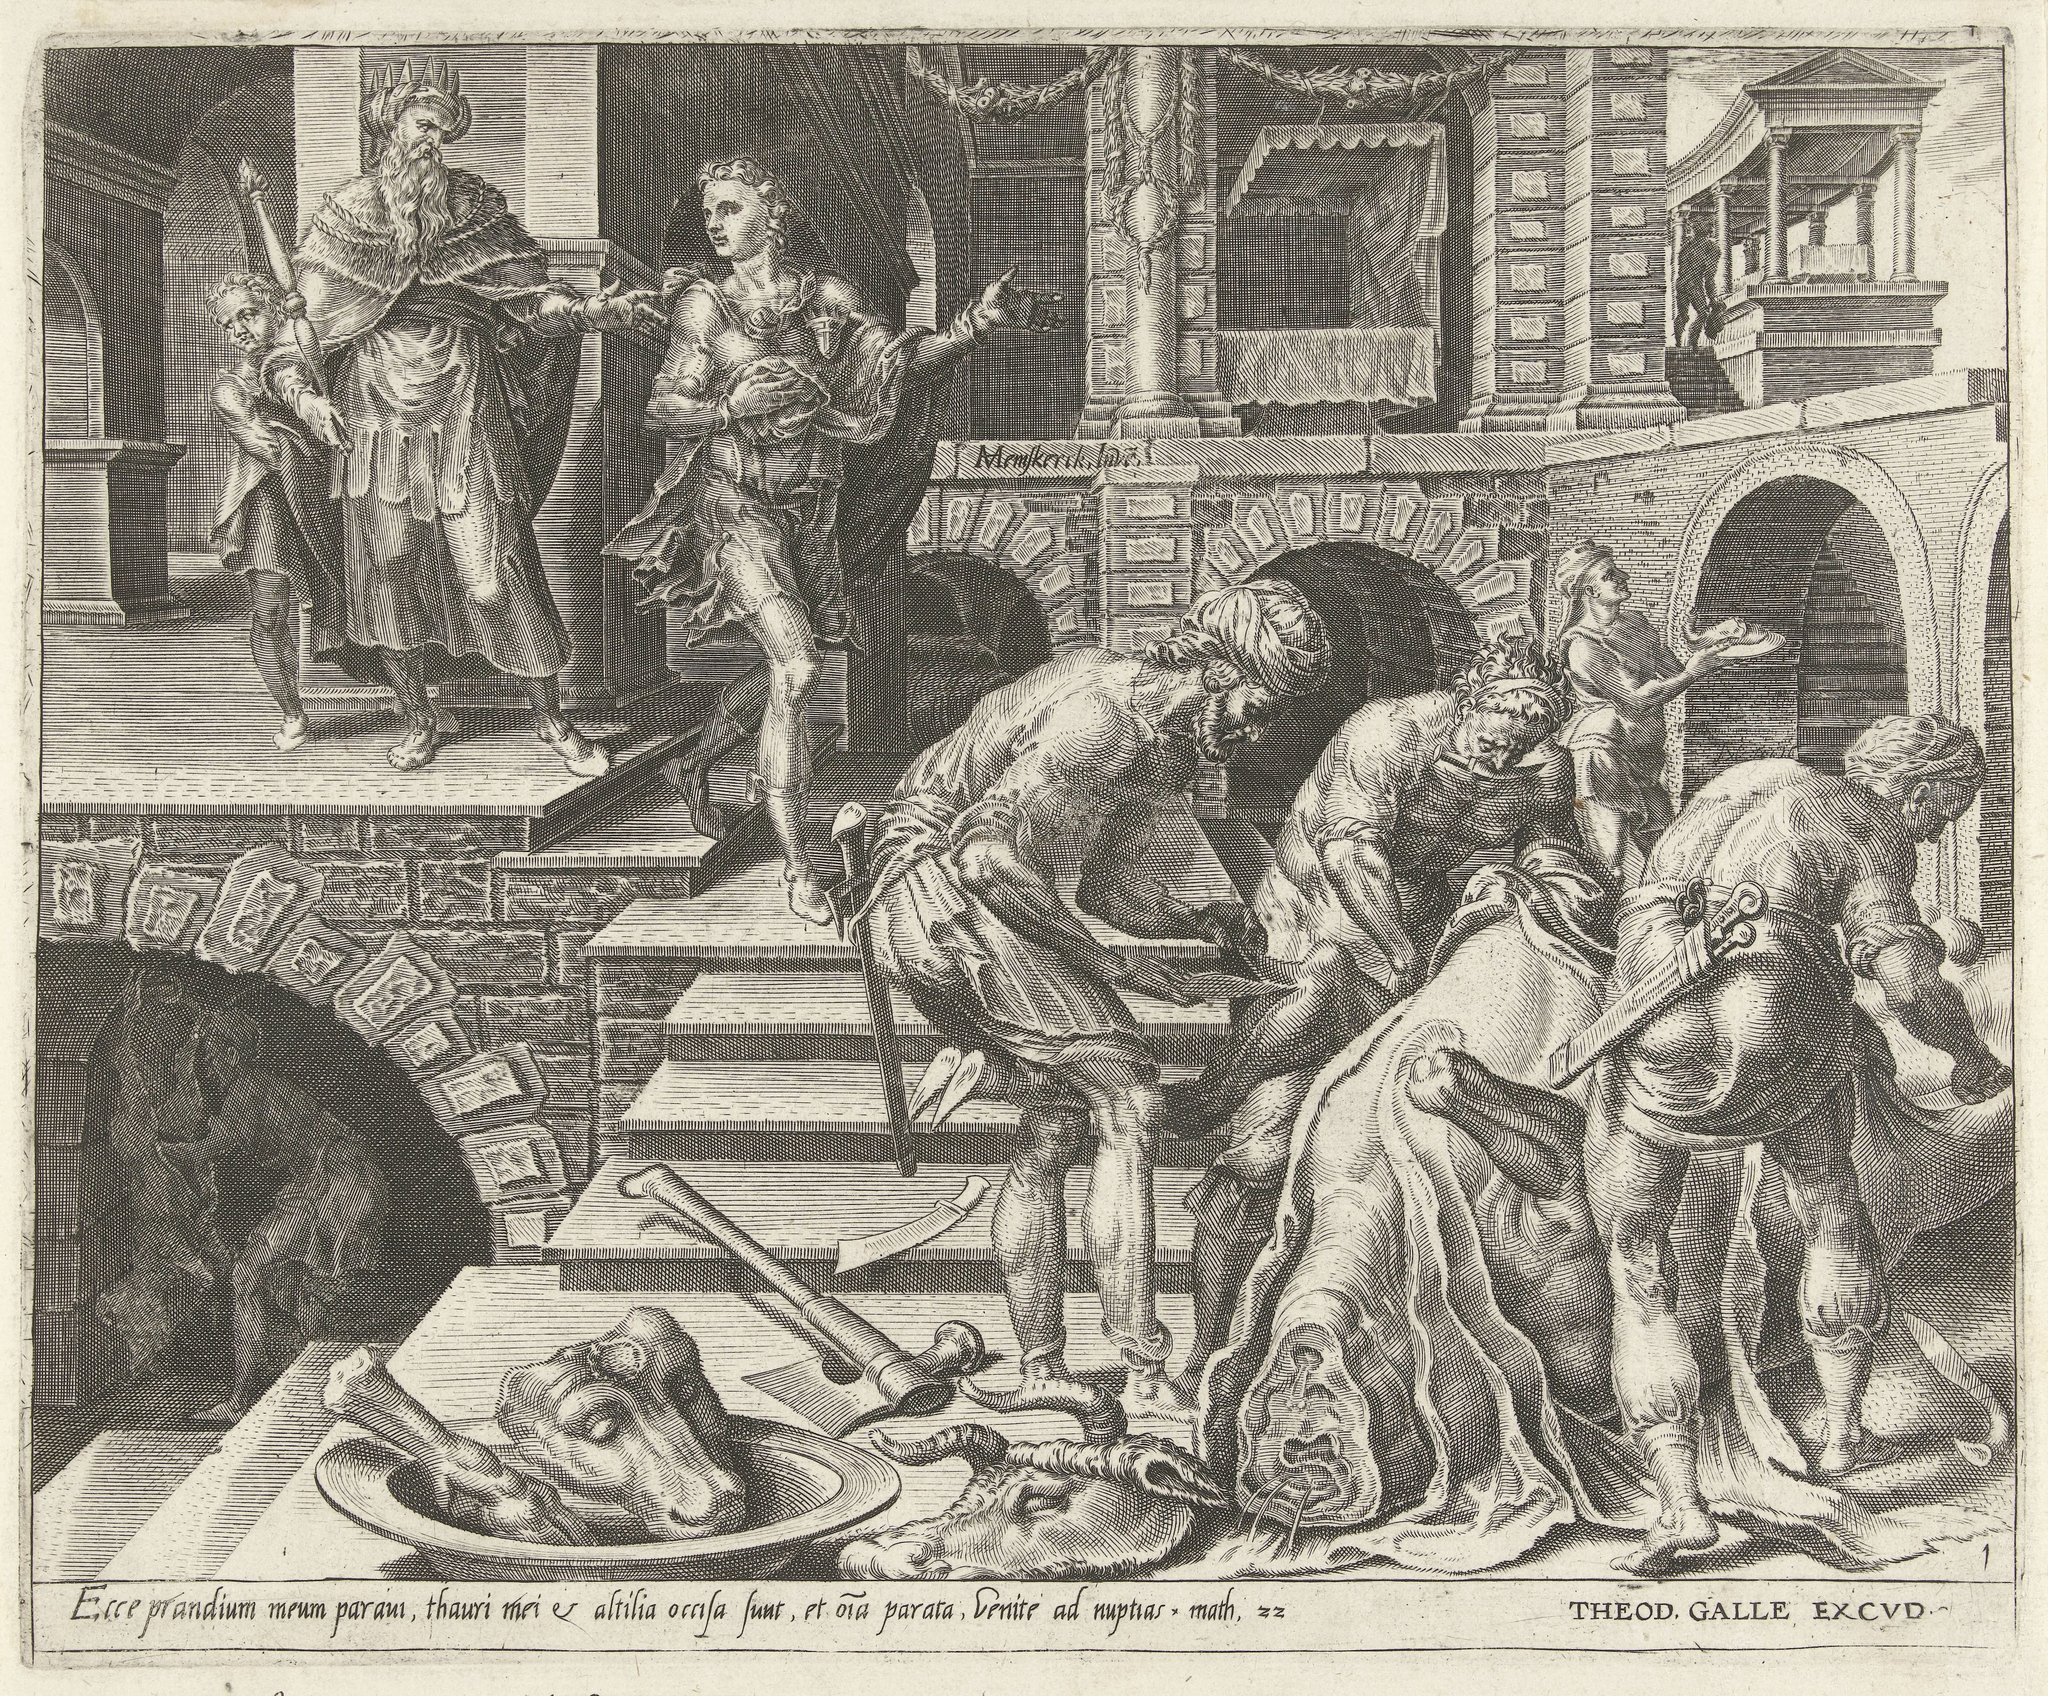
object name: print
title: Gelijkenis van een bruiloftsfeest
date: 1558-1559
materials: paper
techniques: engraving, etching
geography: haarlem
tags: first invitation to the feast ~ parable of the royal wedding-feast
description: De voorbereidingen voor het banket. De koning heeft zijn beste mestvee laten slachten. Hij stuurt zijn dienaren erop uit om de gasten uit te nodigen. De prent heeft een Latijns onderschrift en maakt deel uit van een zesdelige serie over de gelijkenis van een bruiloftsfeest.